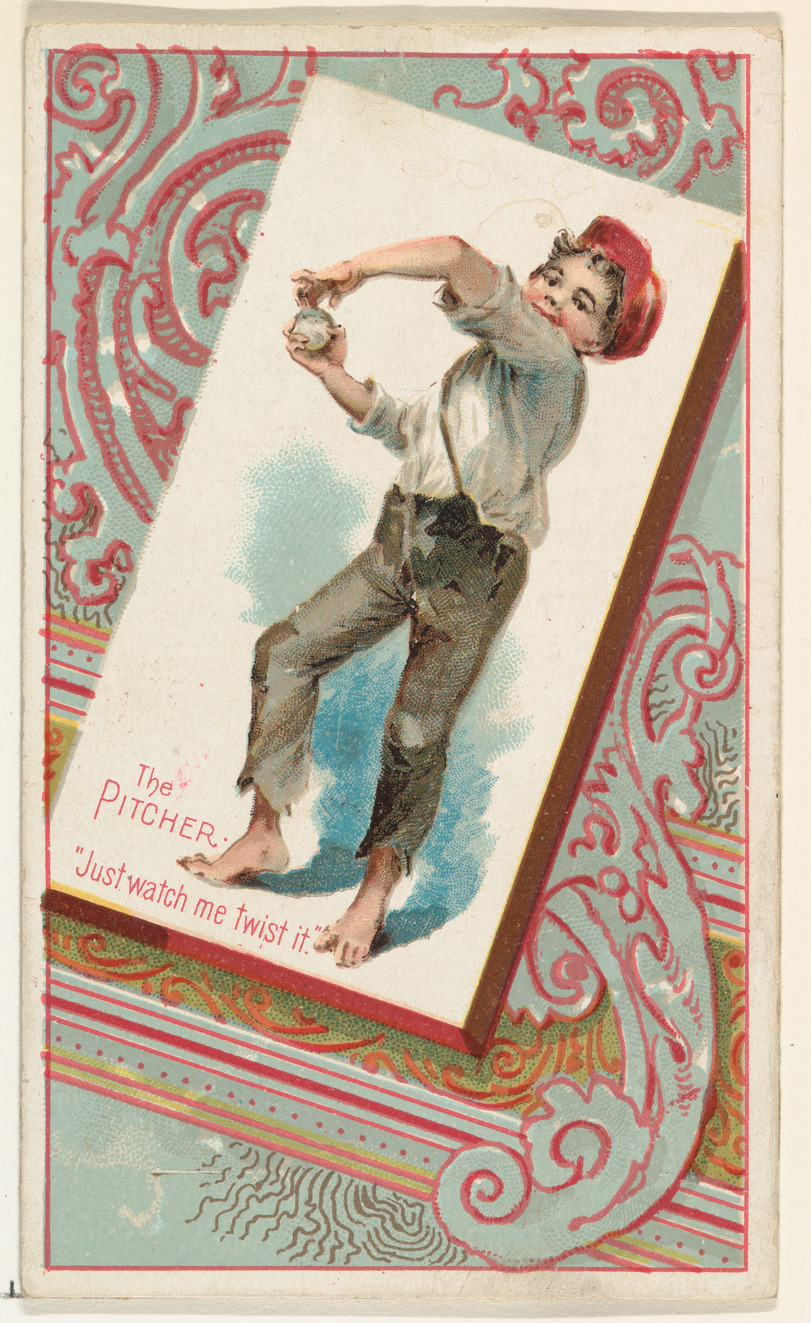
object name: print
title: The Pitcher, "Just watch me twist it," from the Terrors of America set (N136) issued by Duke Sons & Co. to promote Honest Long Cut Tobacco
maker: w. duke, sons & co.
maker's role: publisher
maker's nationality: american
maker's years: 1870-1920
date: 1888-1889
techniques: color lithograph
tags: boys